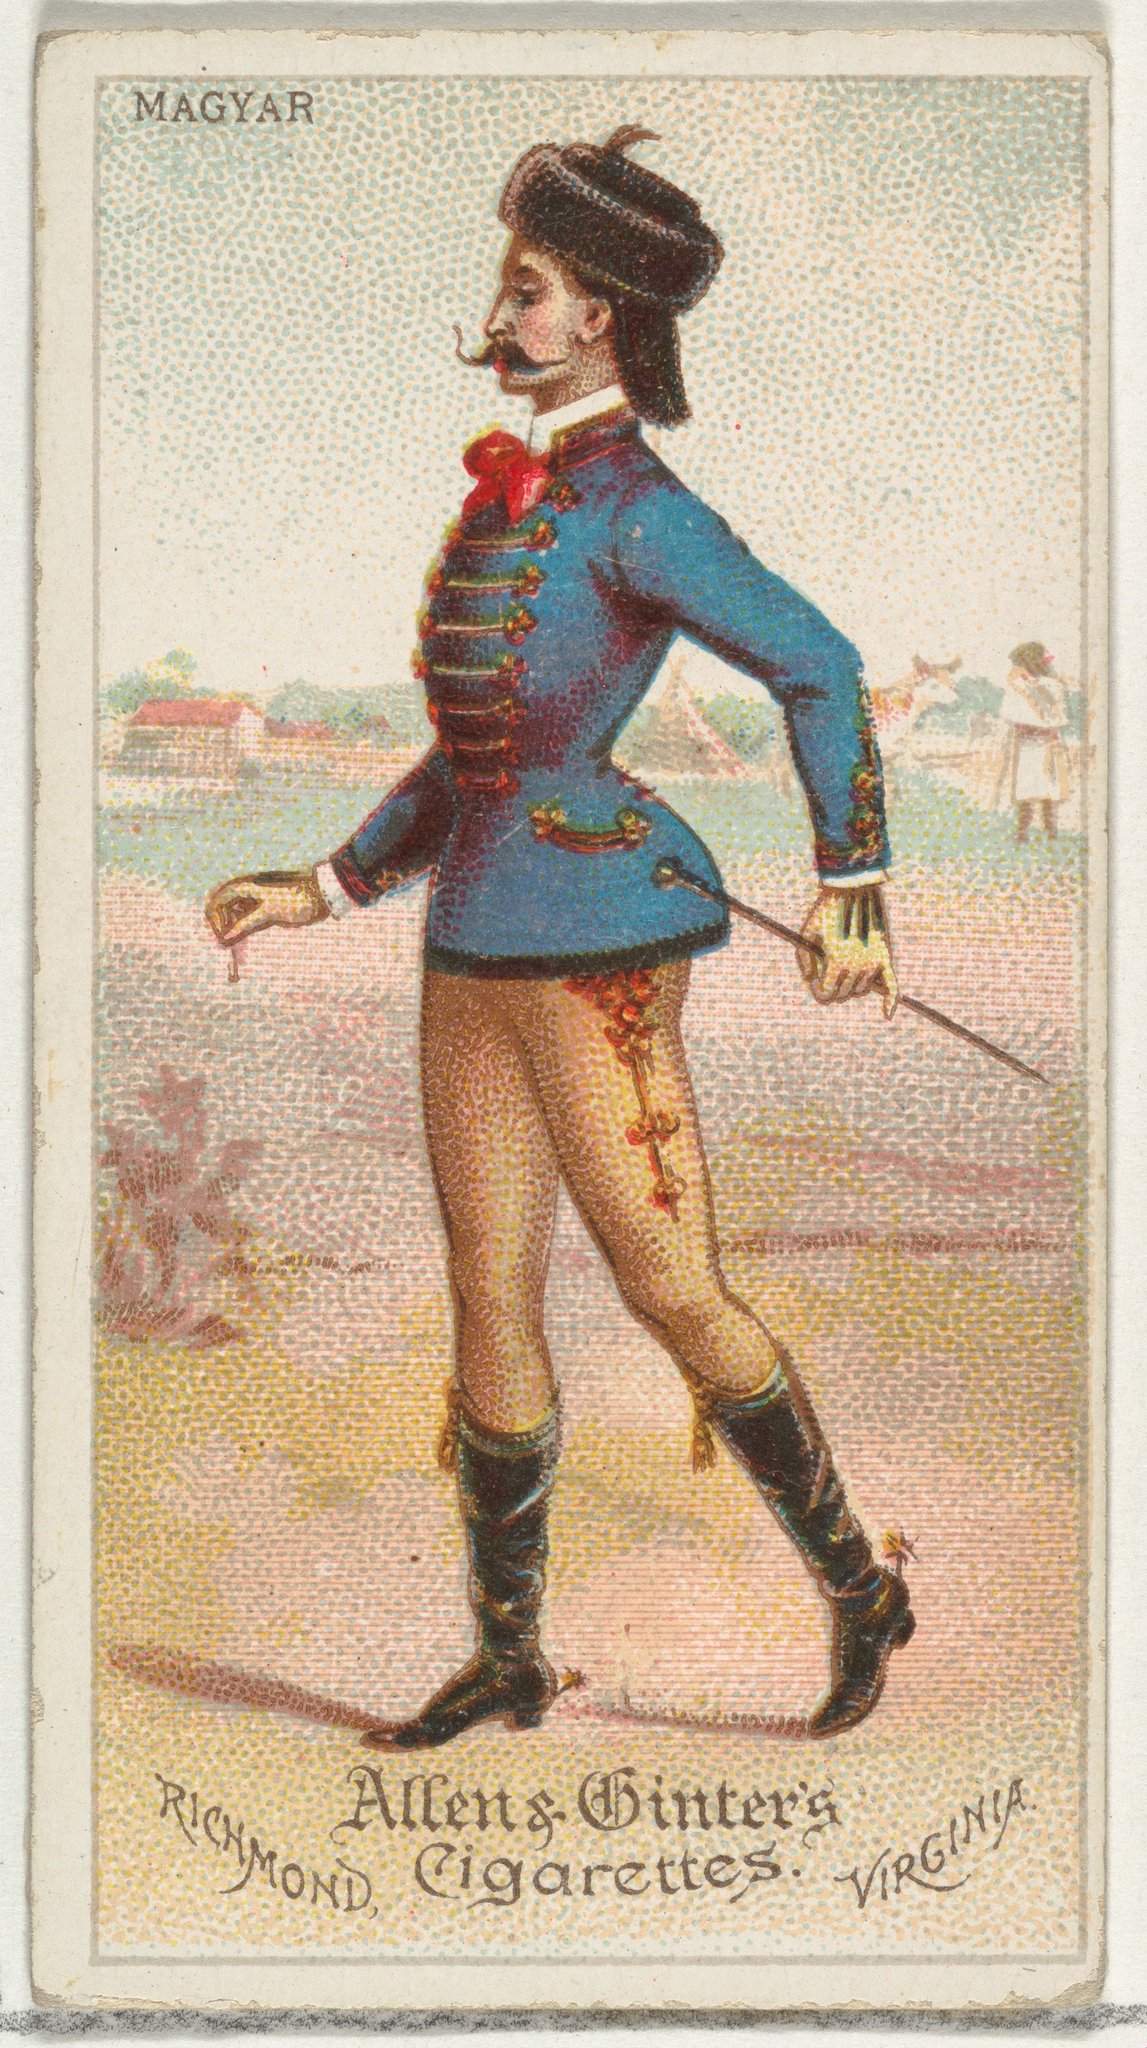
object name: print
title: Magyar, from World's Dudes series (N31) for Allen & Ginter Cigarettes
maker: allen & ginter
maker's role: publisher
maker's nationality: american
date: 1888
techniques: color lithograph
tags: men,profiles